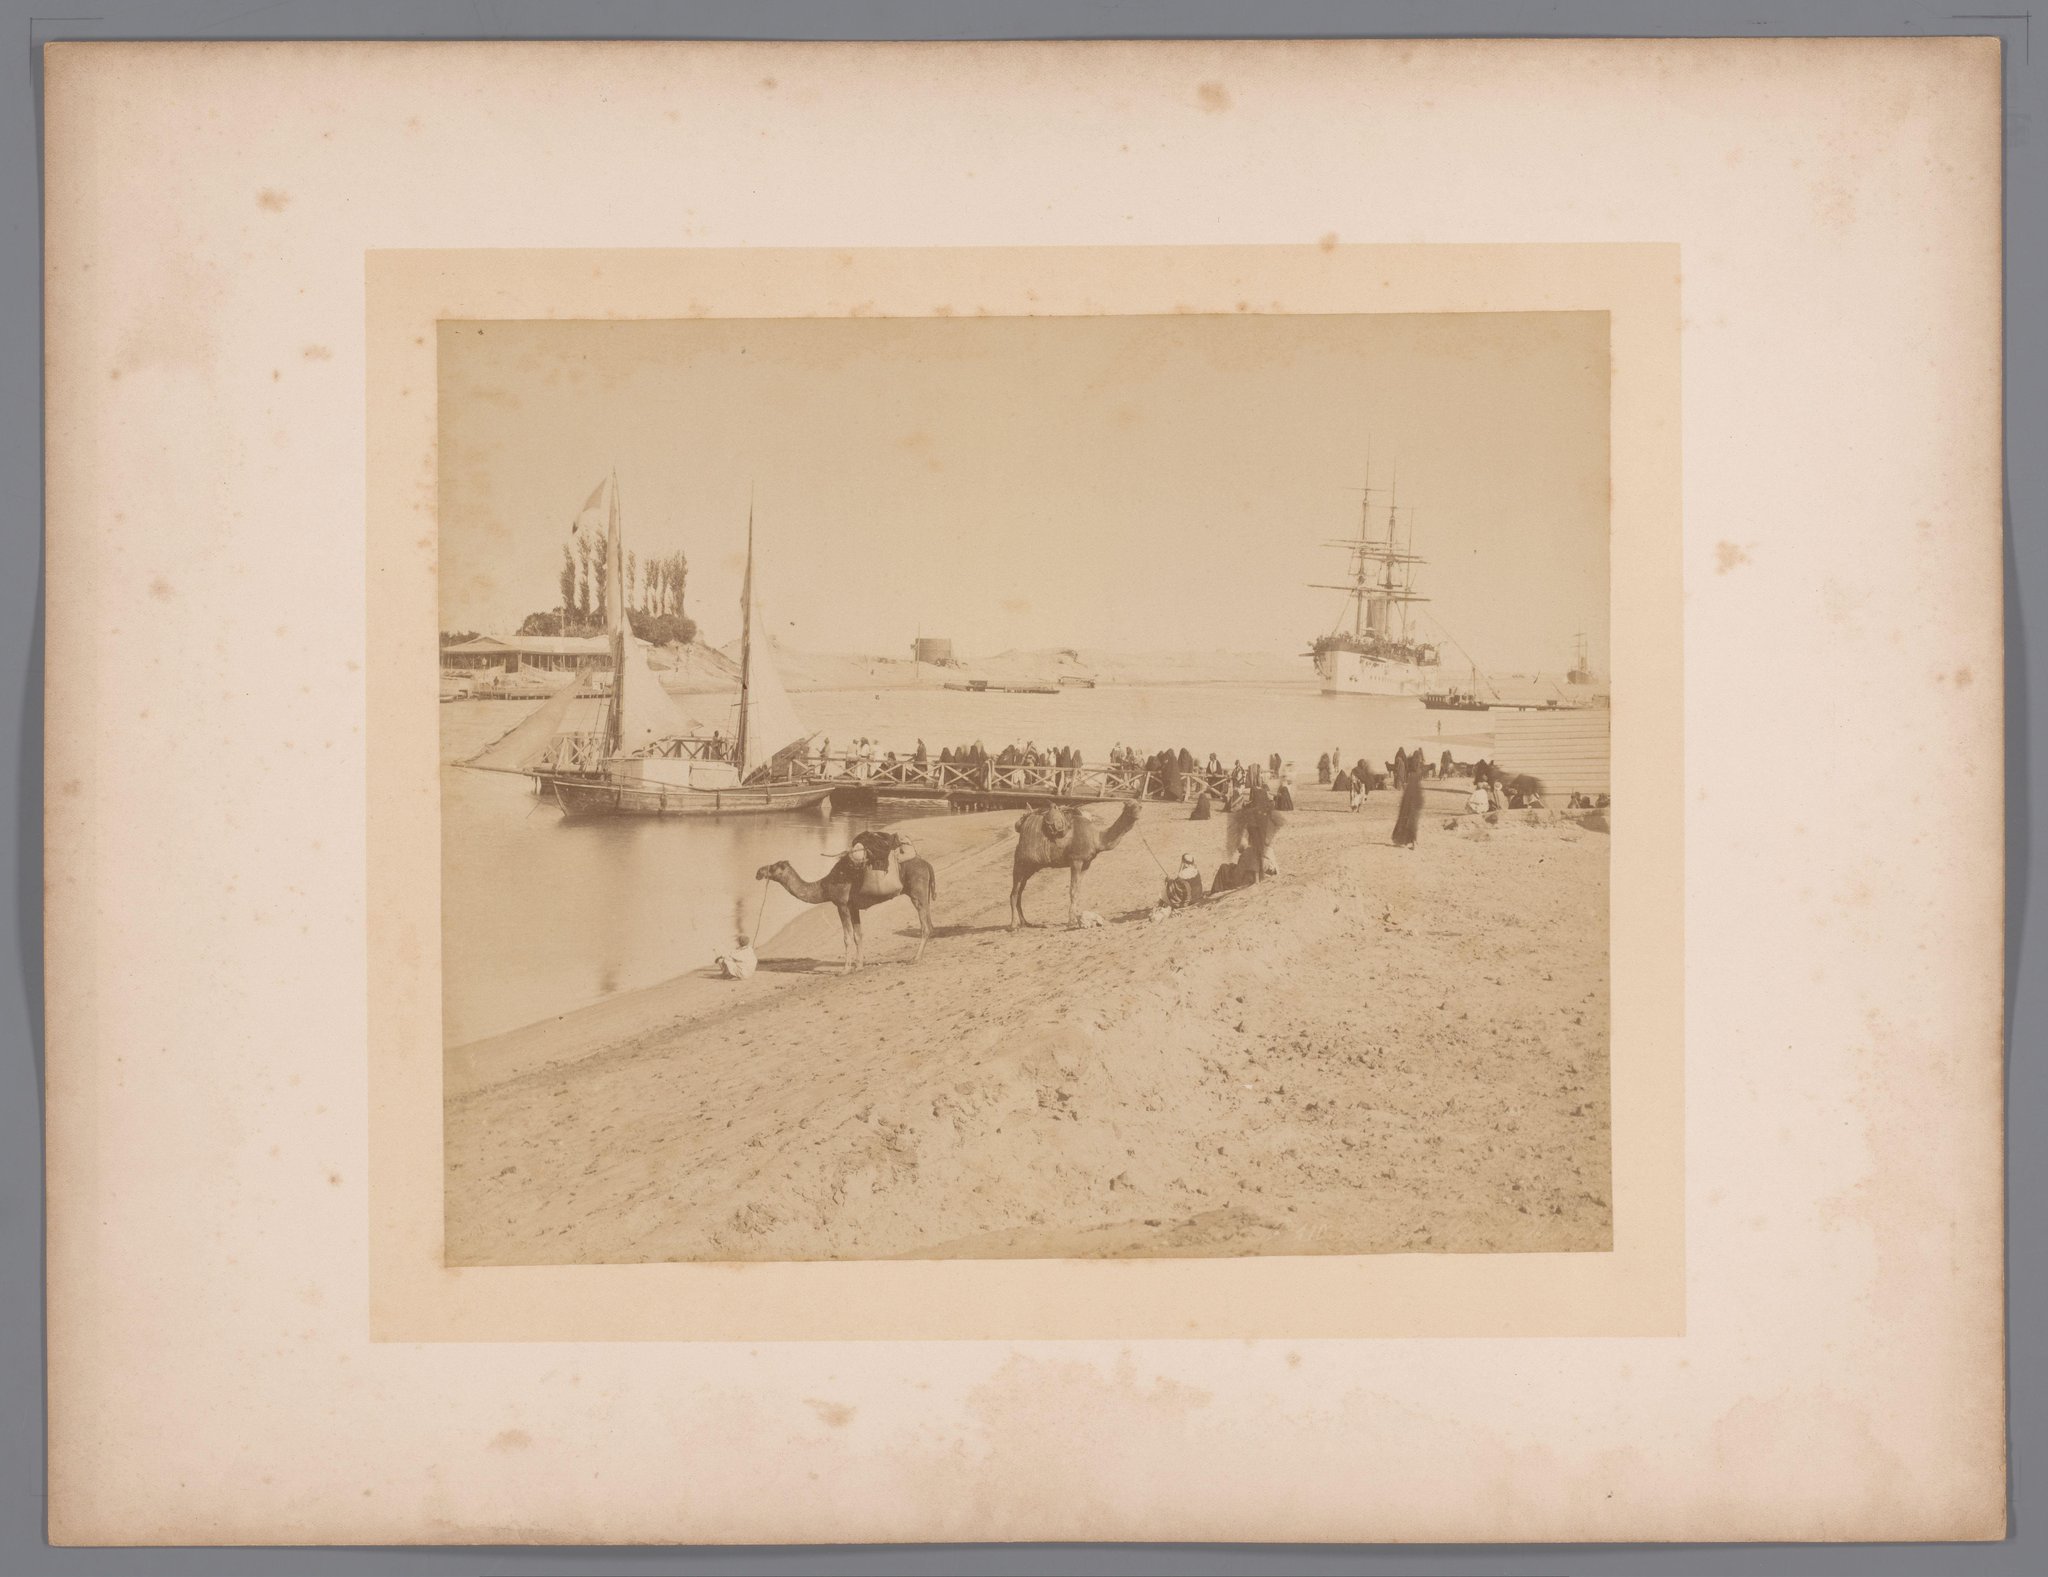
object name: photograph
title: Pont de la Syrie à Kantara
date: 1870-1910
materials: cardboard, paper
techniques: albumen print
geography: al-qantarah gharb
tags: hoofed animals: camel, canal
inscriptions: number: ‘No. 110’